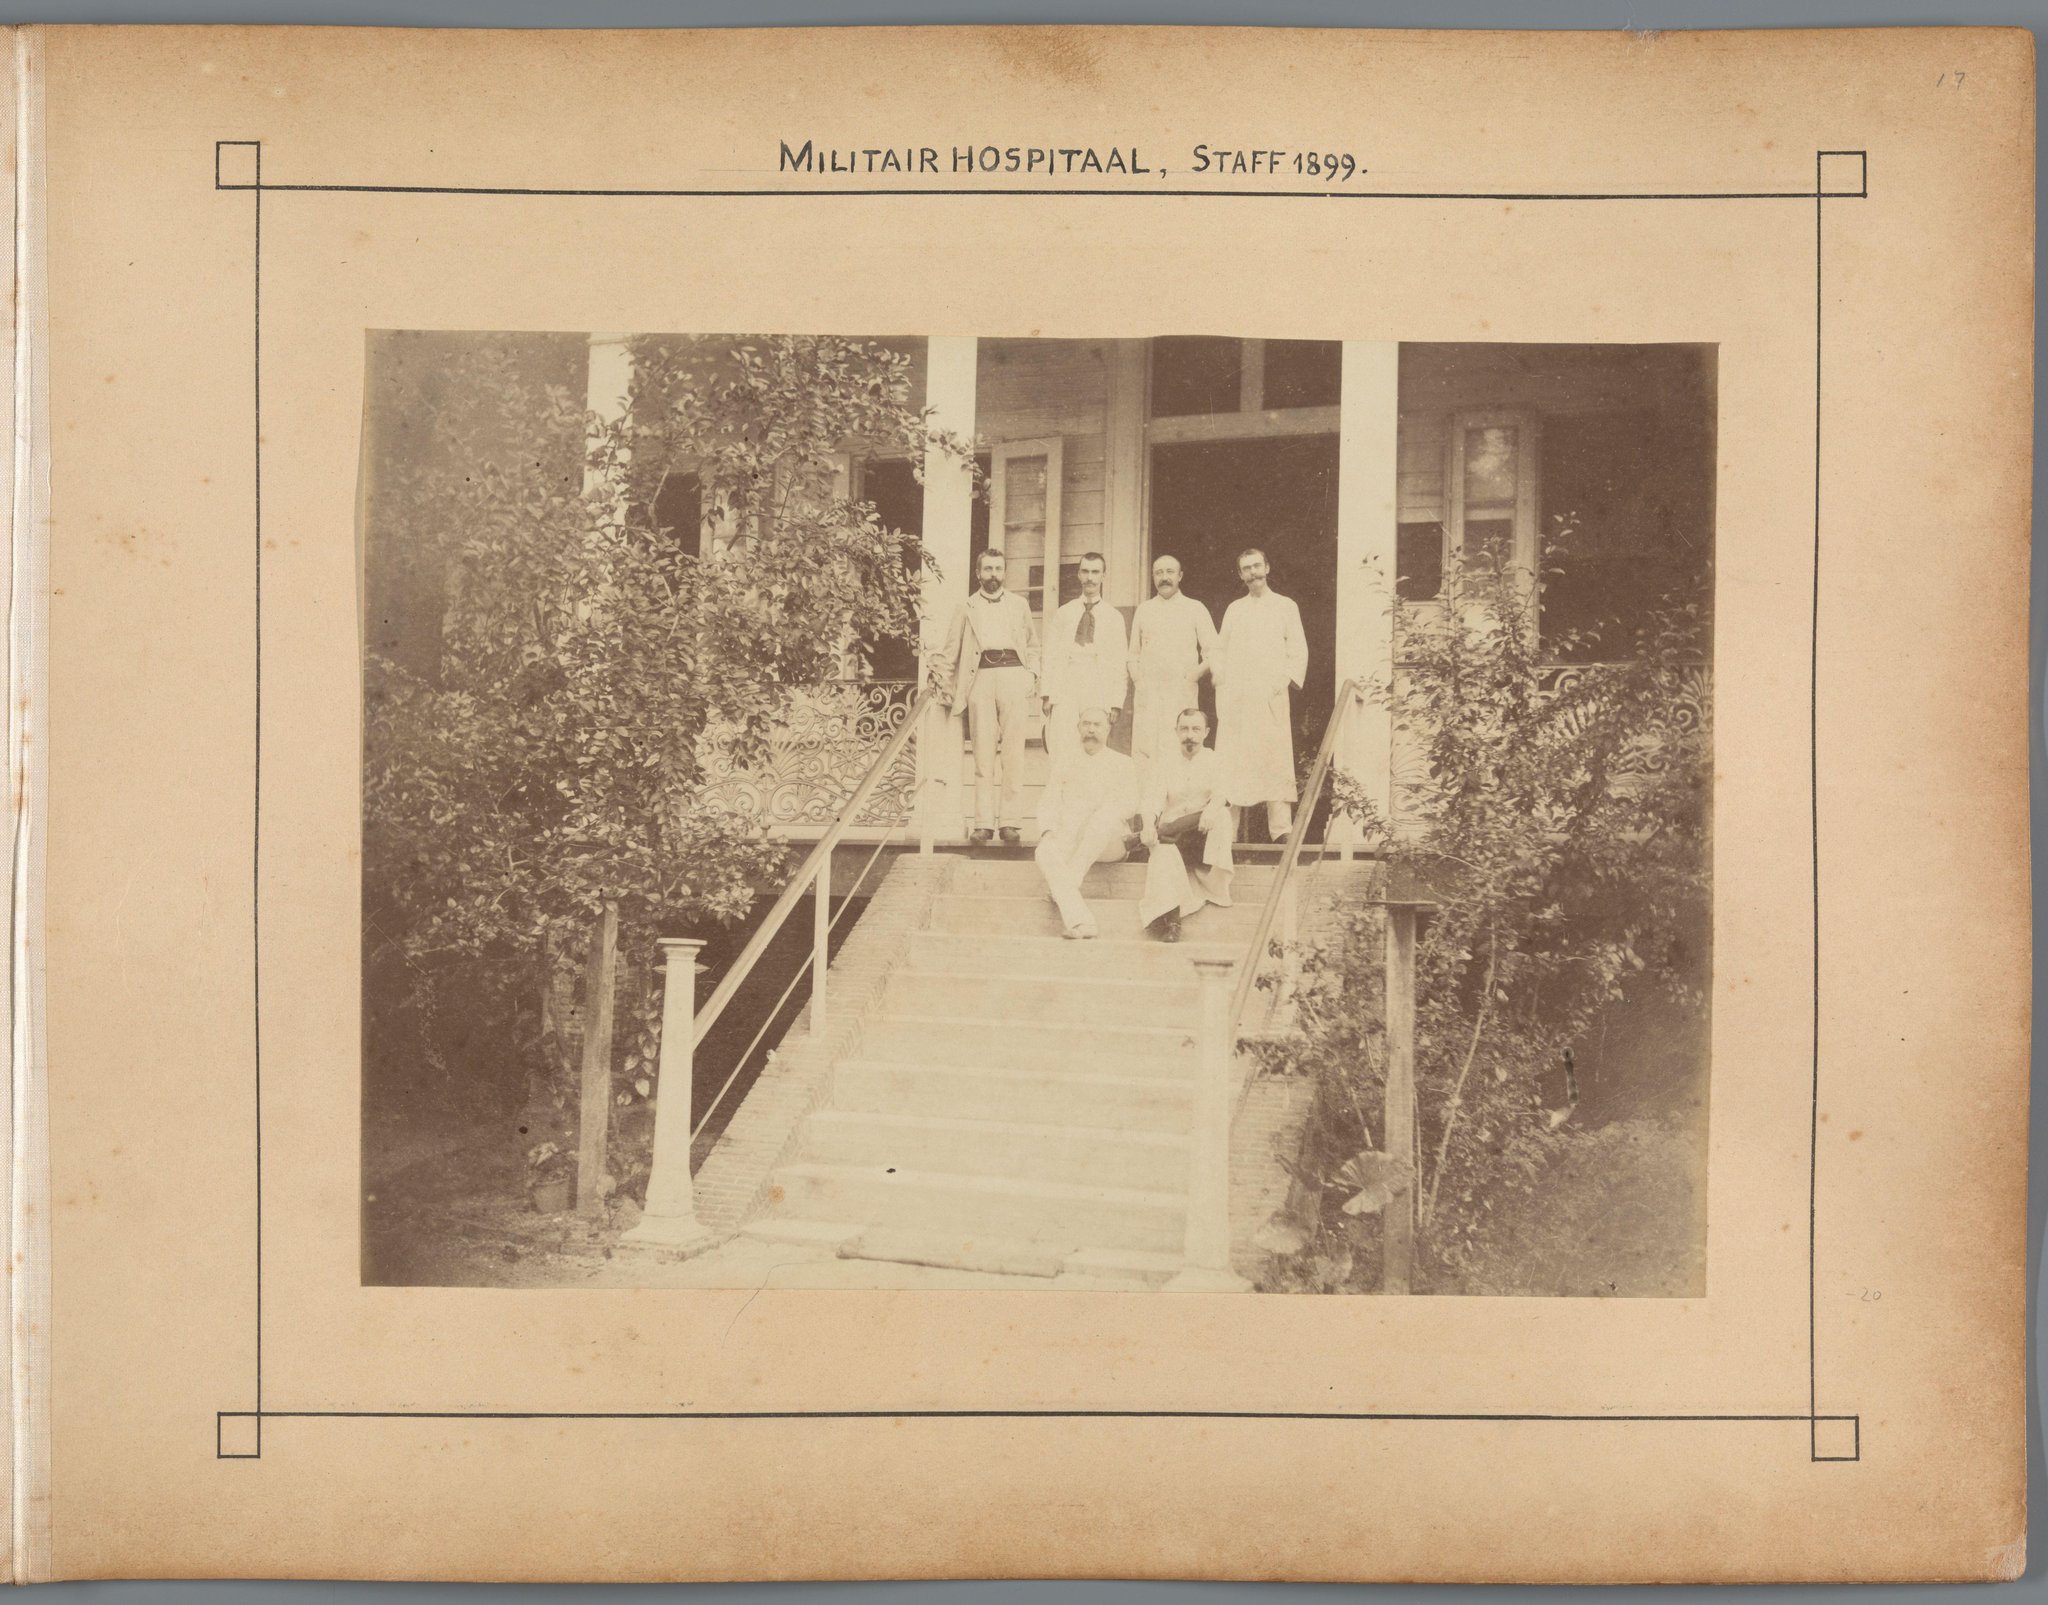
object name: photograph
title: Militair hospitaal, staff 1899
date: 1899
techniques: albumen print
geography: suriname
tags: medical aid and nursing of the sick and wounded, hospital, suriname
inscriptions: date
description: Staf poseerend op de trap van het Militair hospitaal (nu 's Lands Hospitaal), 1899.